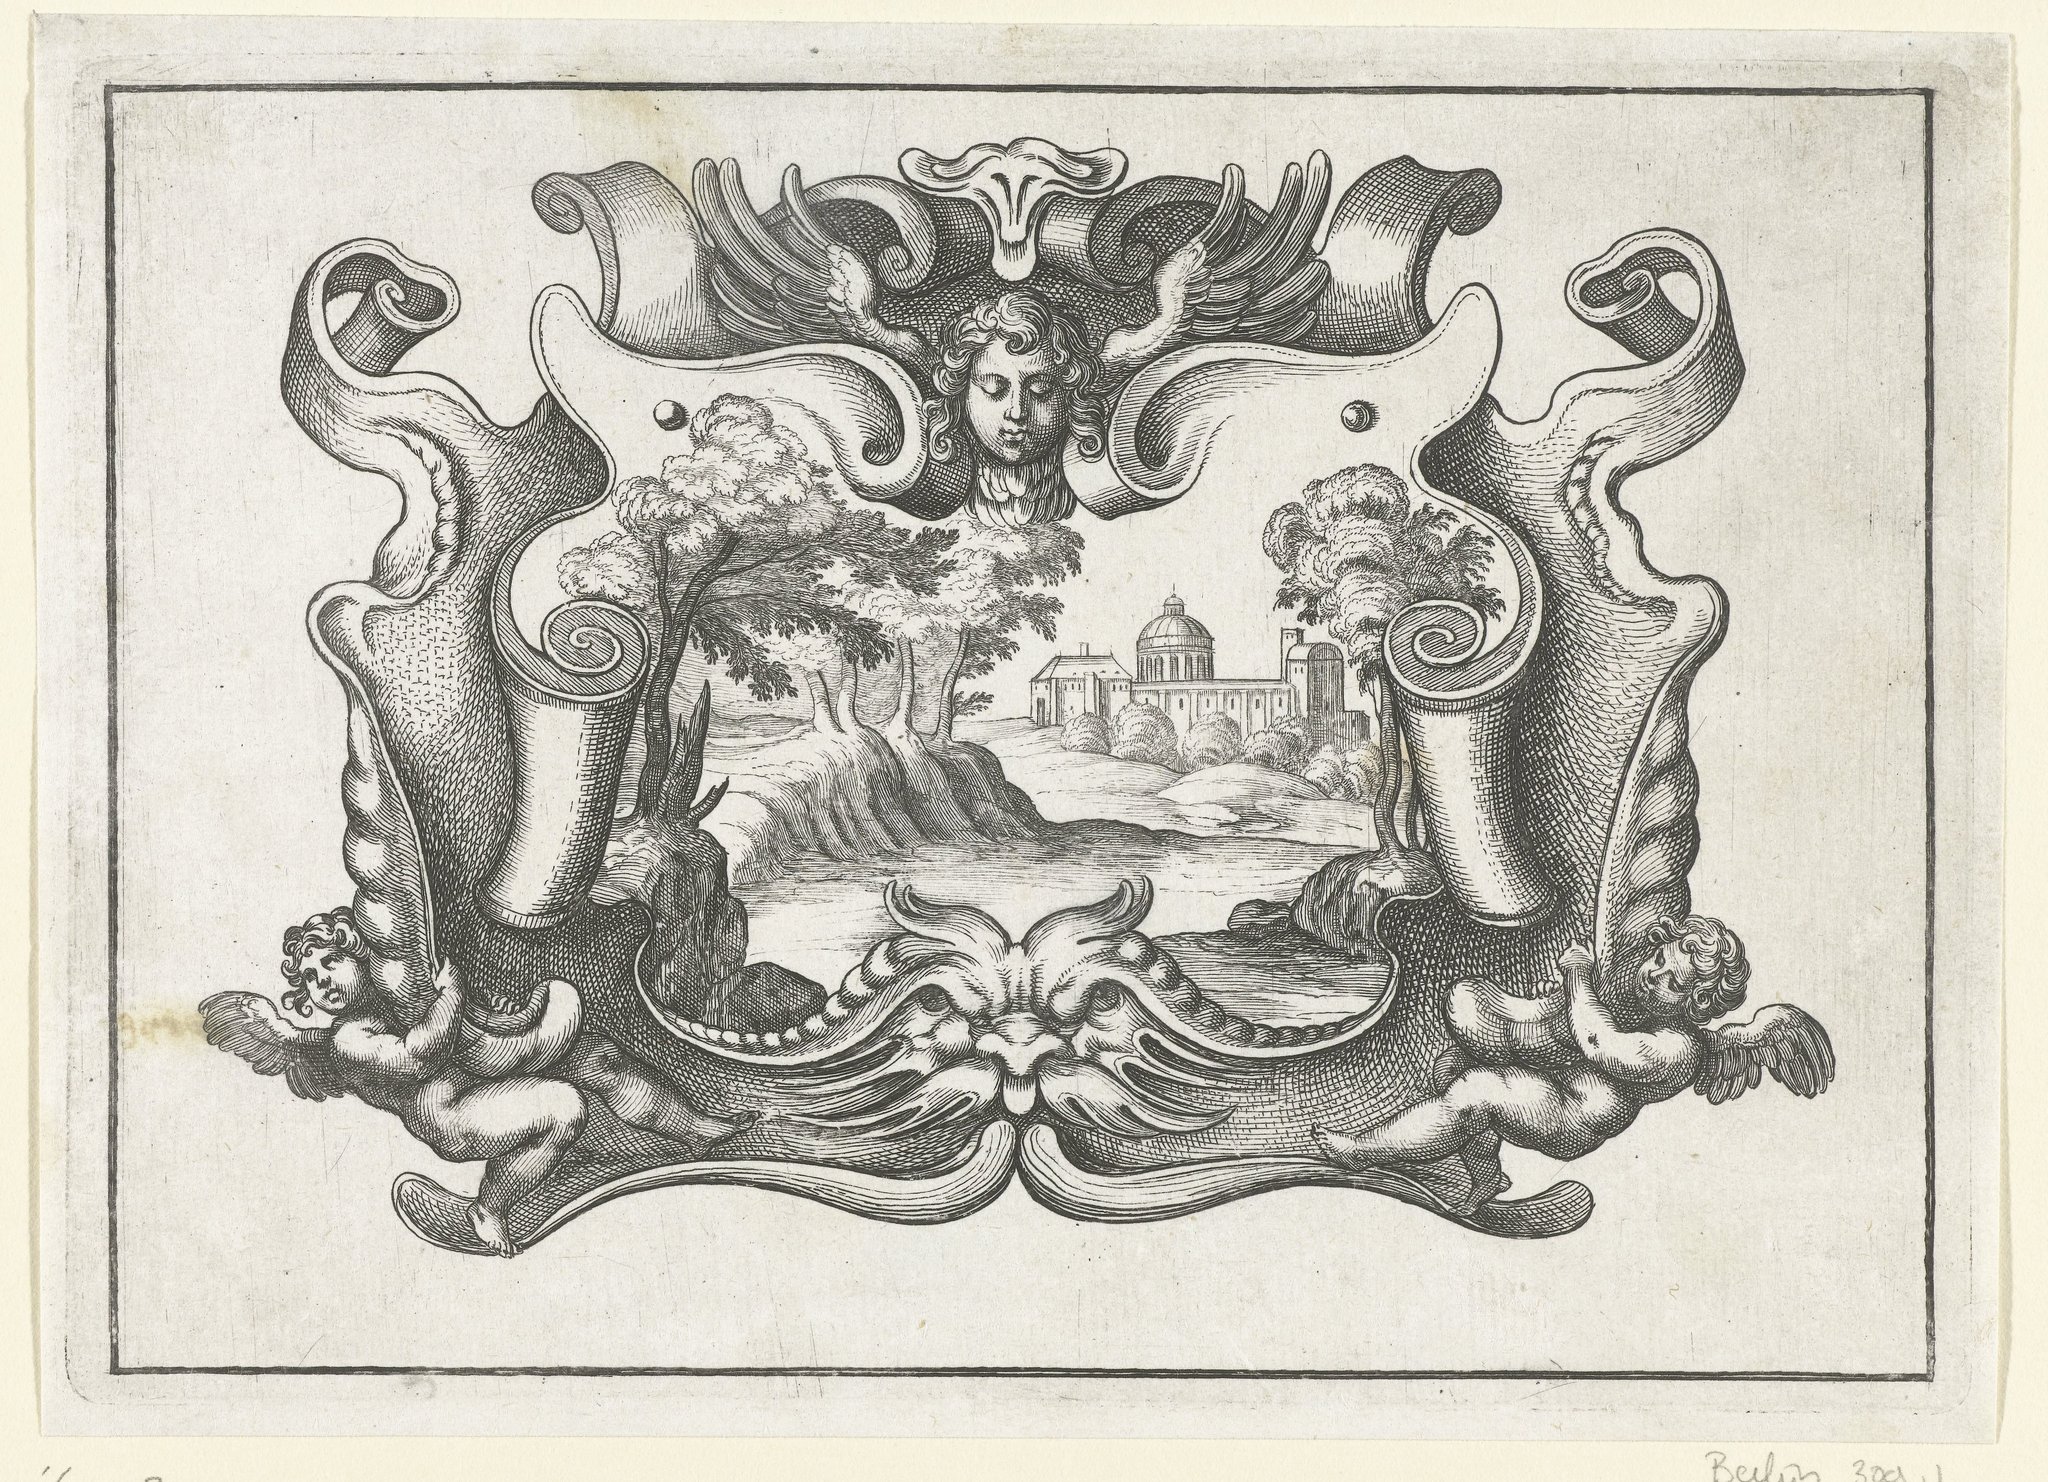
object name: print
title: Cartouche met cherubijn en twee putti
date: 1634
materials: paper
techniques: engraving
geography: france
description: In het compartiment staat een landschap met bomen en een kerk afgebeeld. Blad 9 uit serie van 13 bladen met cartouches in Franse kwabstijl. Uit eerste editie.